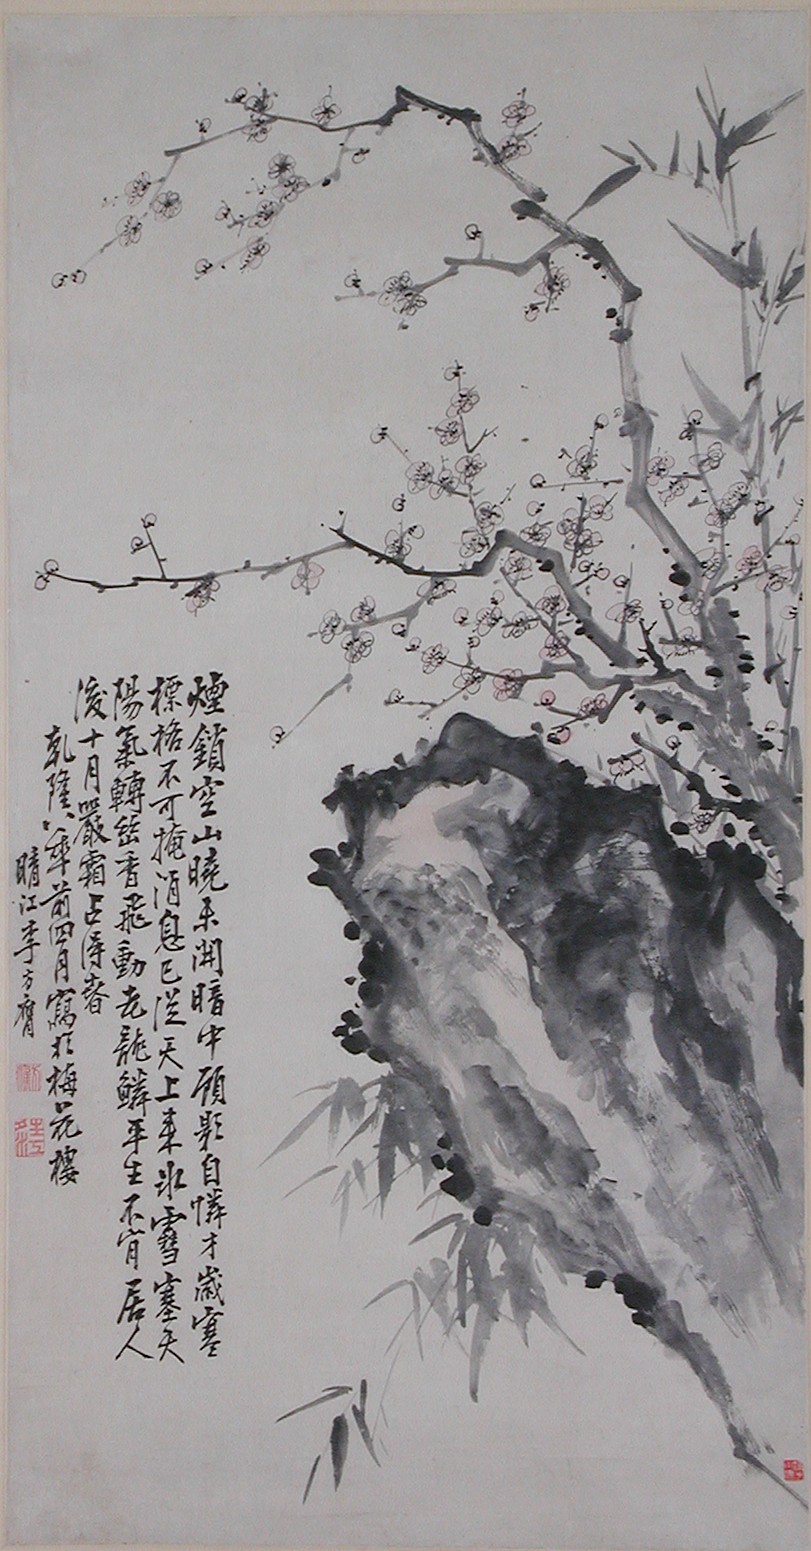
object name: hanging scroll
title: Bamboo, plum, and rock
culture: chinese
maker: li fangying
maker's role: artist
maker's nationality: chinese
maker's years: 1696-1754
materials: ink, paper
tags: bamboo